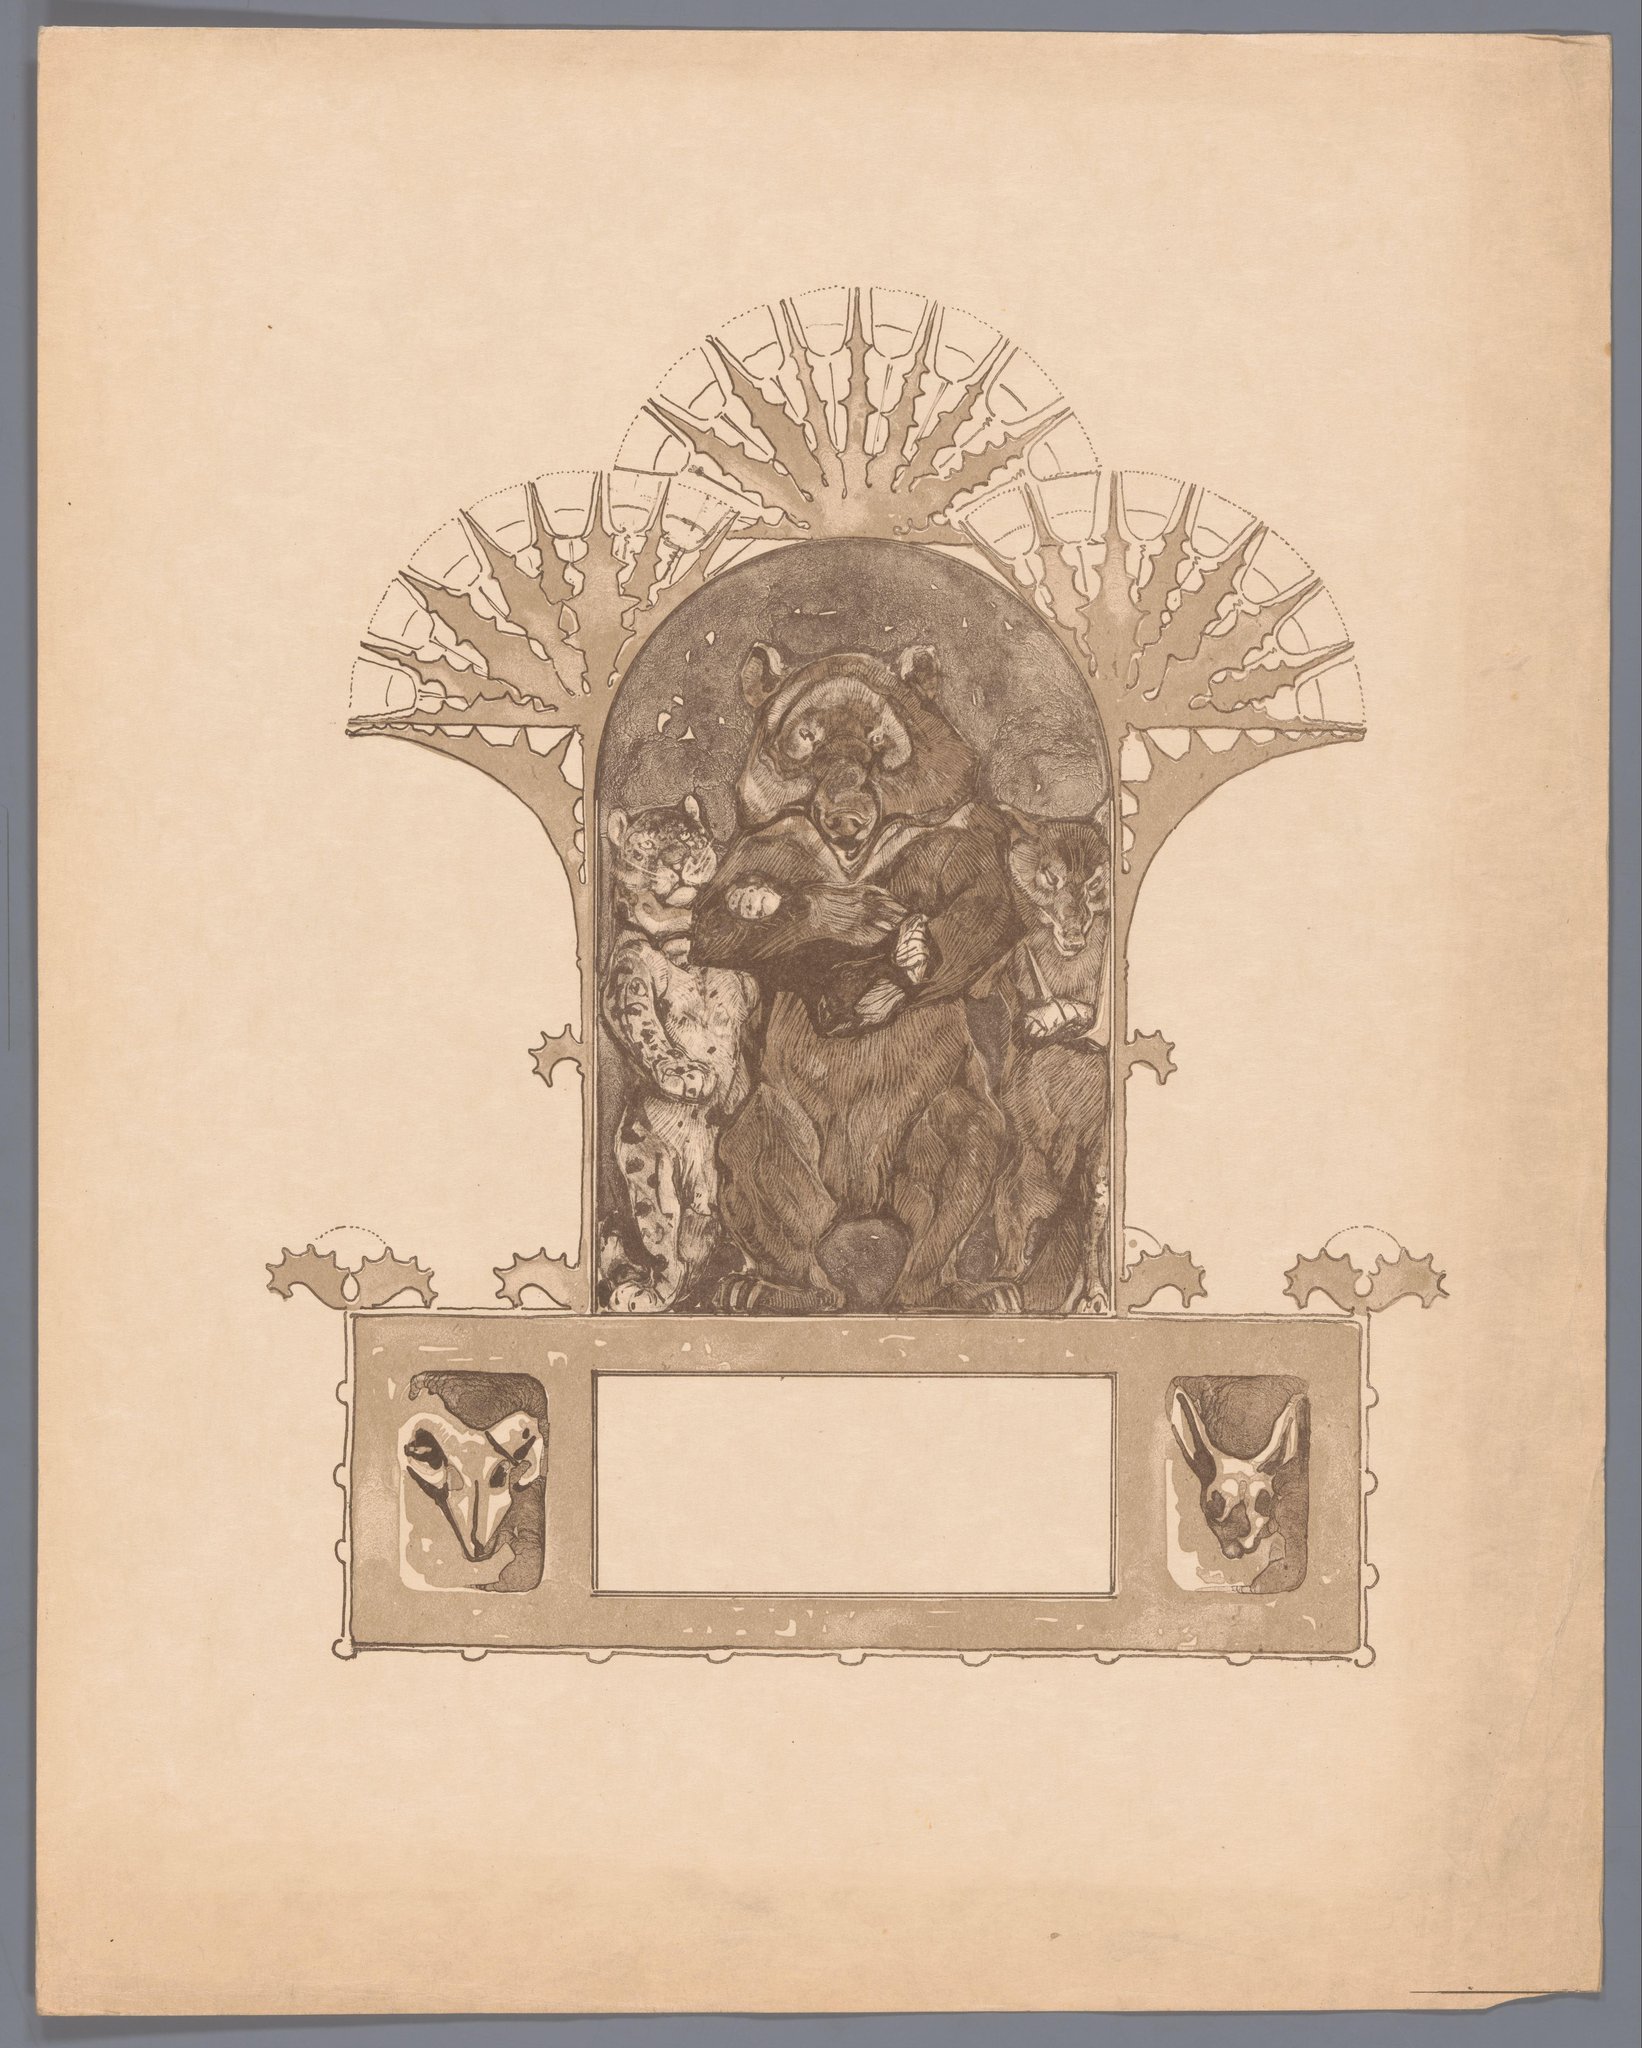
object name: print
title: Luipaard, beer en wolf (Firapeel, Bruun en Isegrim)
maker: bernard willem wierink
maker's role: draughtsman, print maker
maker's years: 1856-1939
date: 1910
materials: paper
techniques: lithograph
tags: fable of reynard the fox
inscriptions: collector's mark: Lugt 2228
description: Ontwerp voor: Streuvels, Stijn (Frank Lateur). Reinaert de Vos naar verschillende uitgaven van het middeleeuwsche epos. Amsterdam: L.J. Veen, 1910.